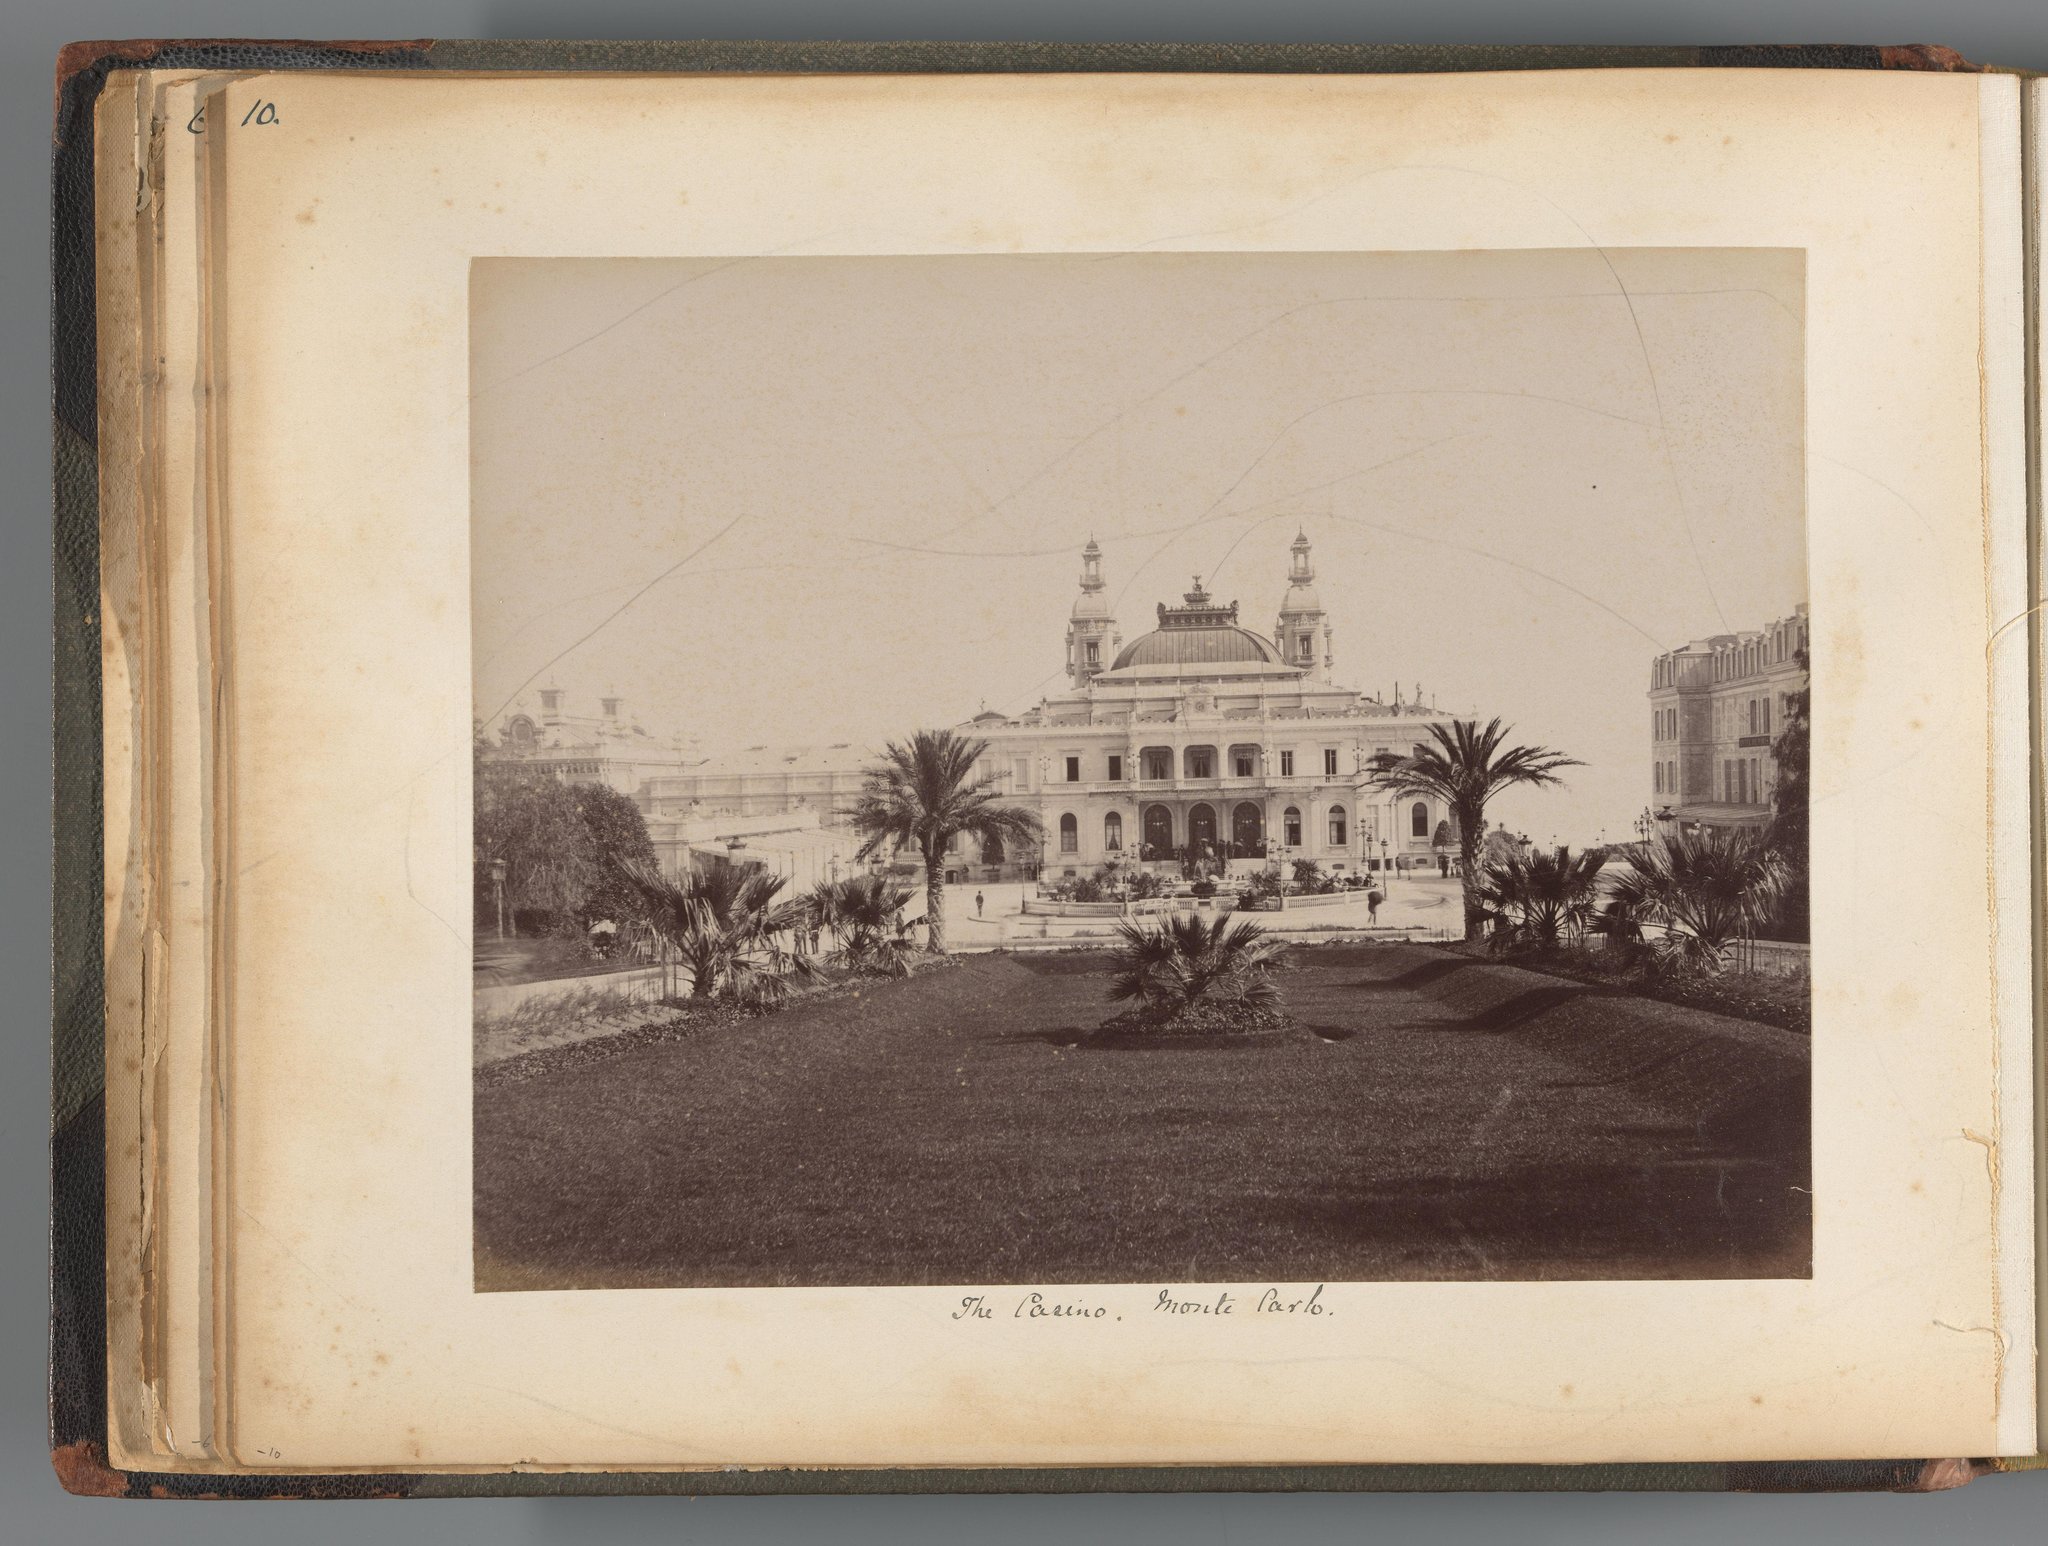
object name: photograph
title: The casino, Monte Carlo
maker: c.c. blackburn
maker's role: fotograaf, luitenant-kolonel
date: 1888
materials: paper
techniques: albumen print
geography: monaco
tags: casino